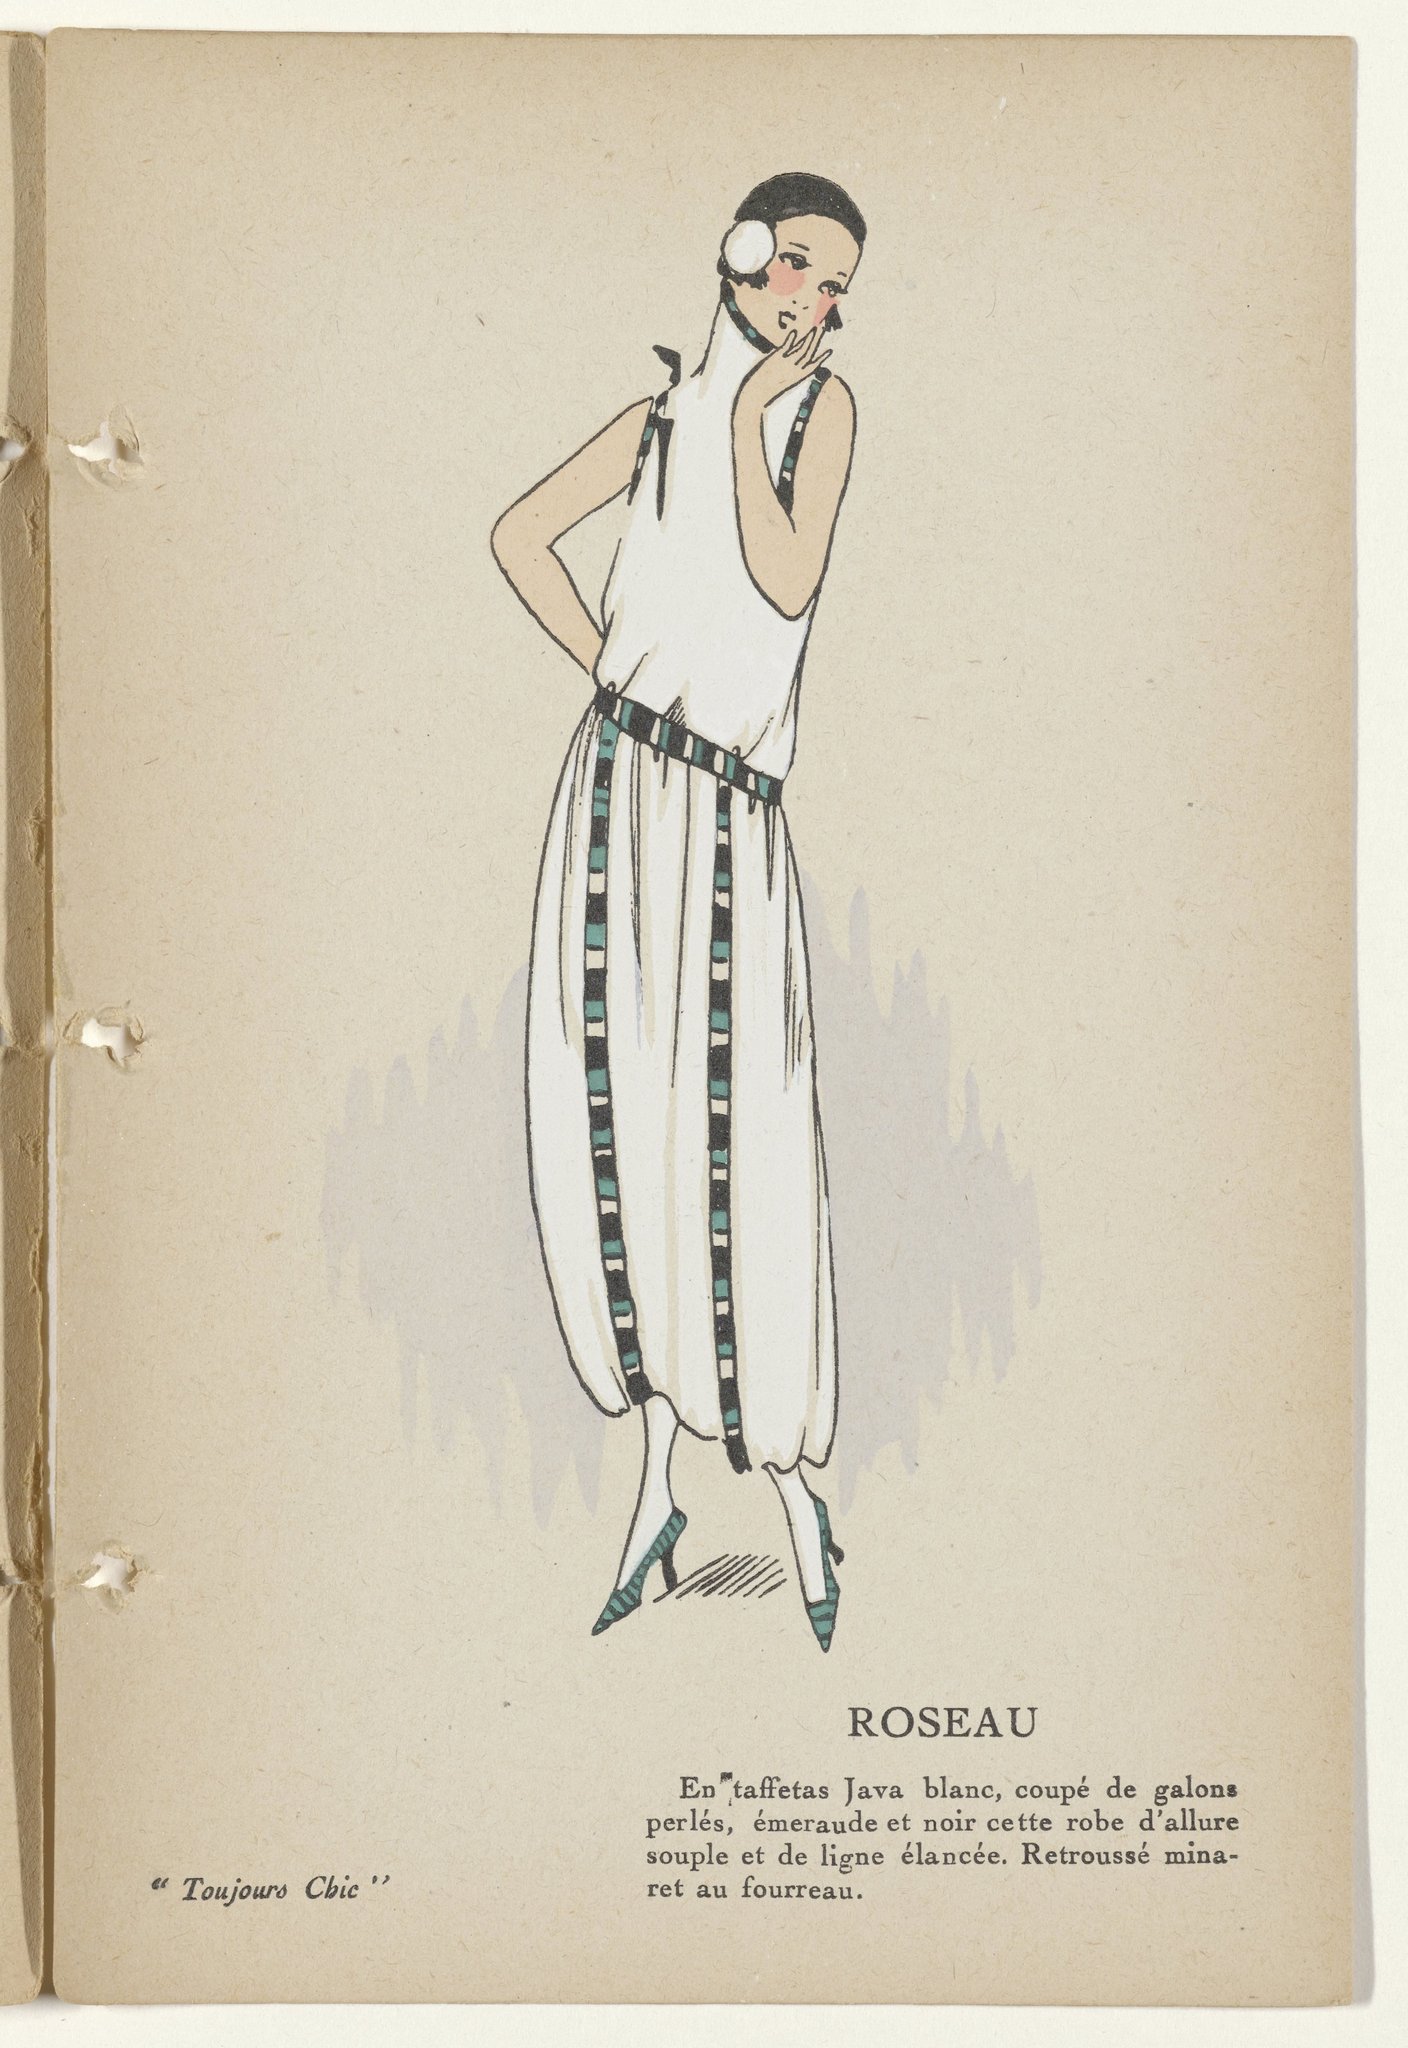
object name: titelprent, frontispice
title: Toujours Chic, Toilettes de Soirées, Hiver 1921-1922: Roseau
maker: g-p. joumard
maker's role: publisher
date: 1921-1922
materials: paper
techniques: letterpress printing, pochoir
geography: paris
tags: fashion plates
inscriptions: date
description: Prent uit Catalogus "Toujours Chic" waarin een overzicht van de wintermode 1921-1922 in 80 prentjes in pochoir techniek.